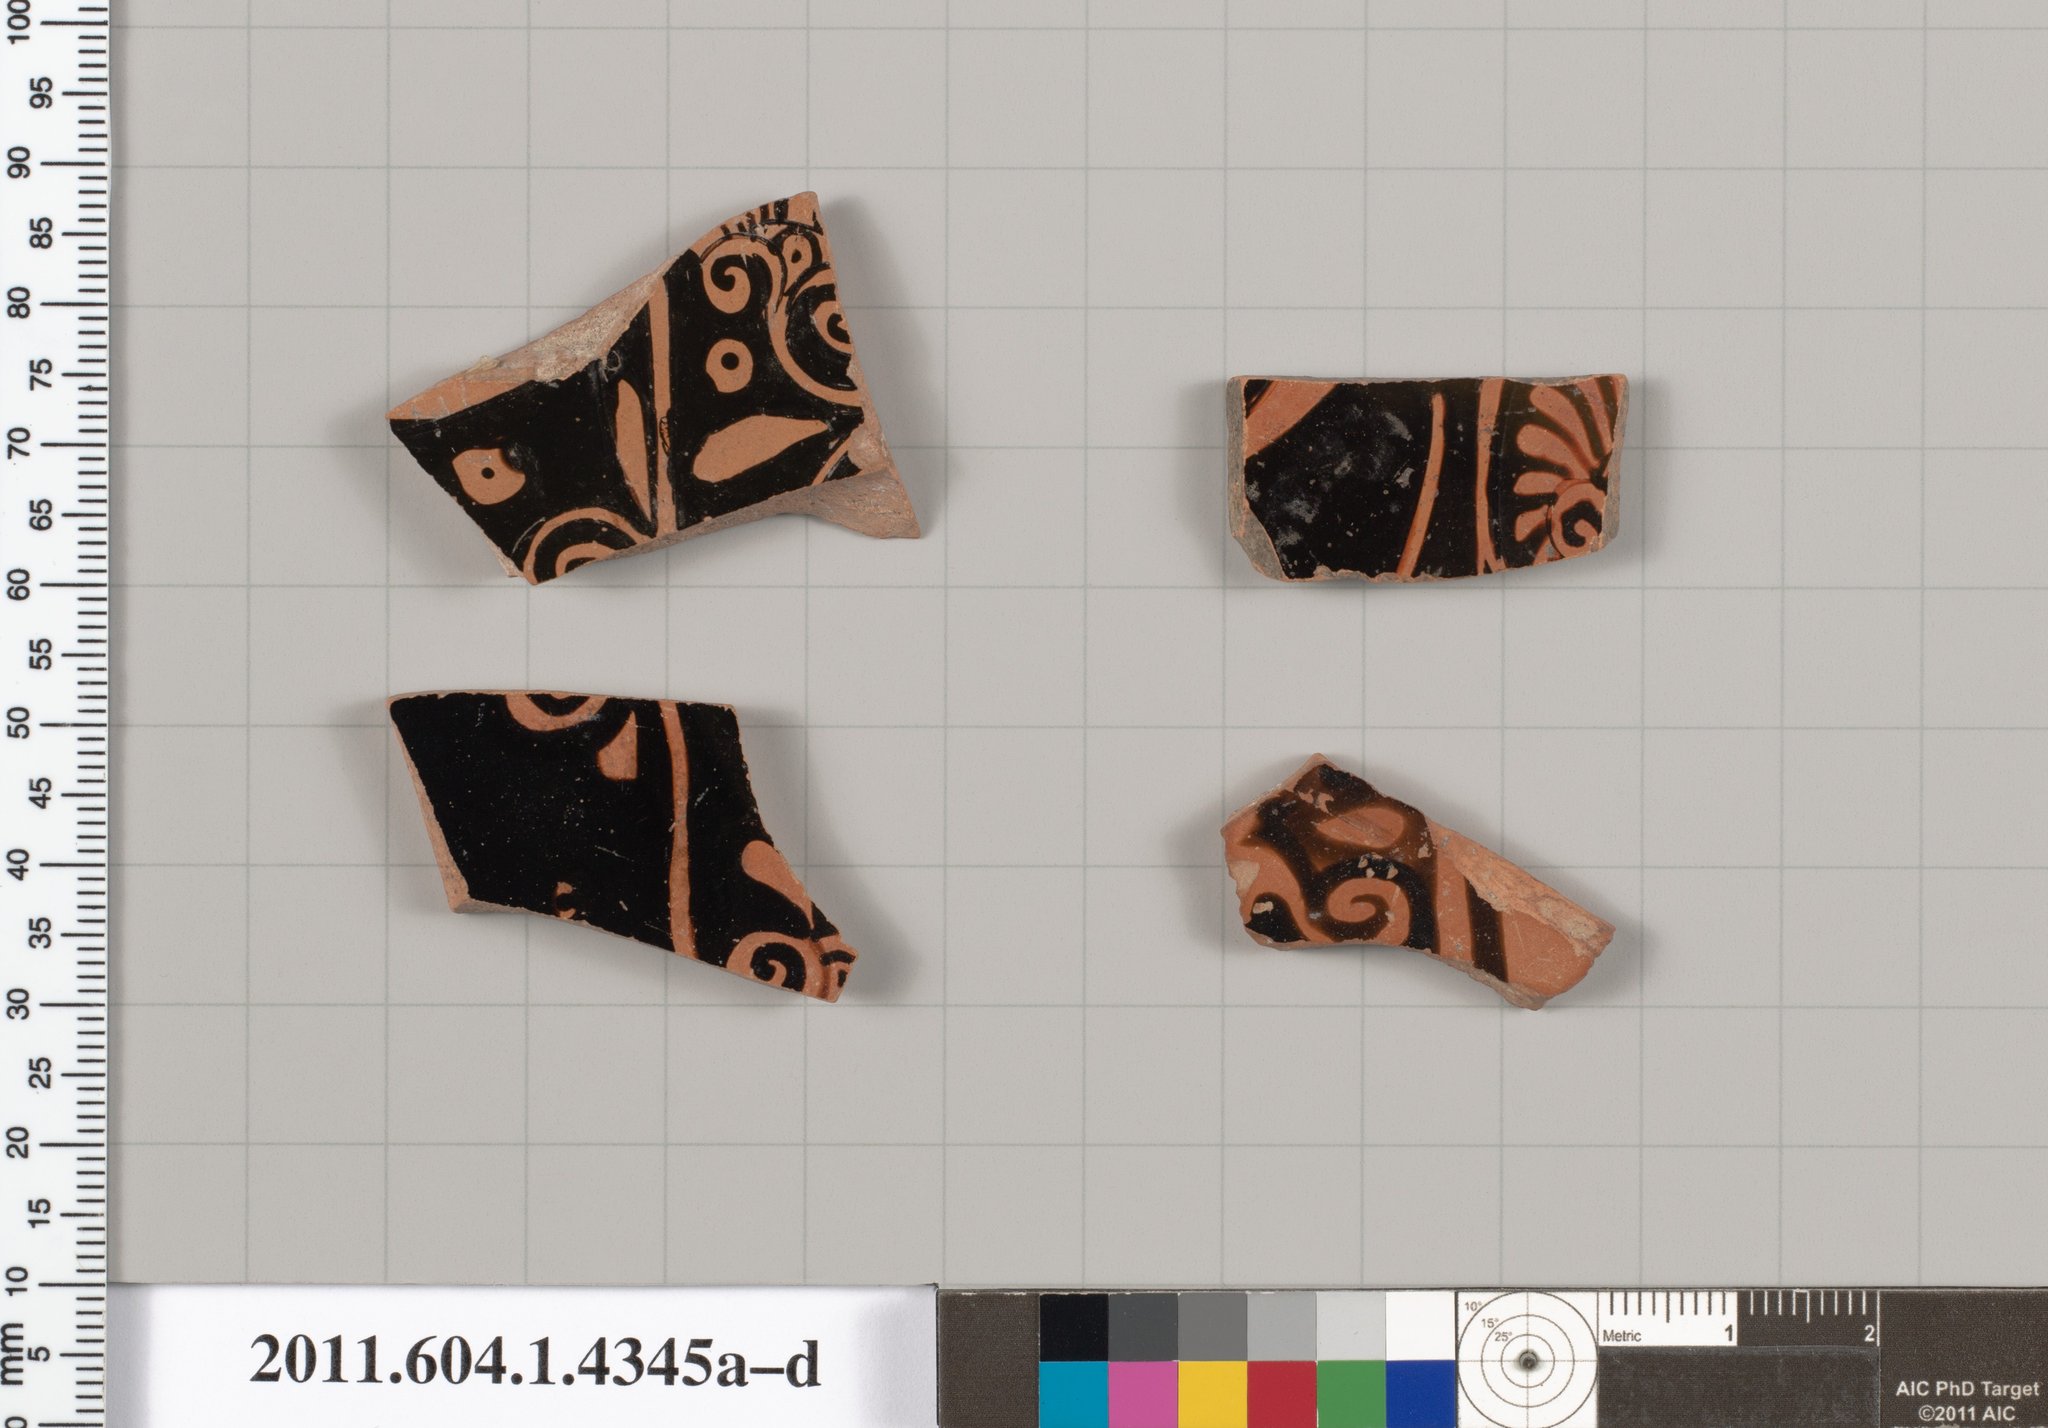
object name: kylix fragment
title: Terracotta fragments of kylikes (drinking cups)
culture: greek, attic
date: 500-451 BCE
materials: terracotta